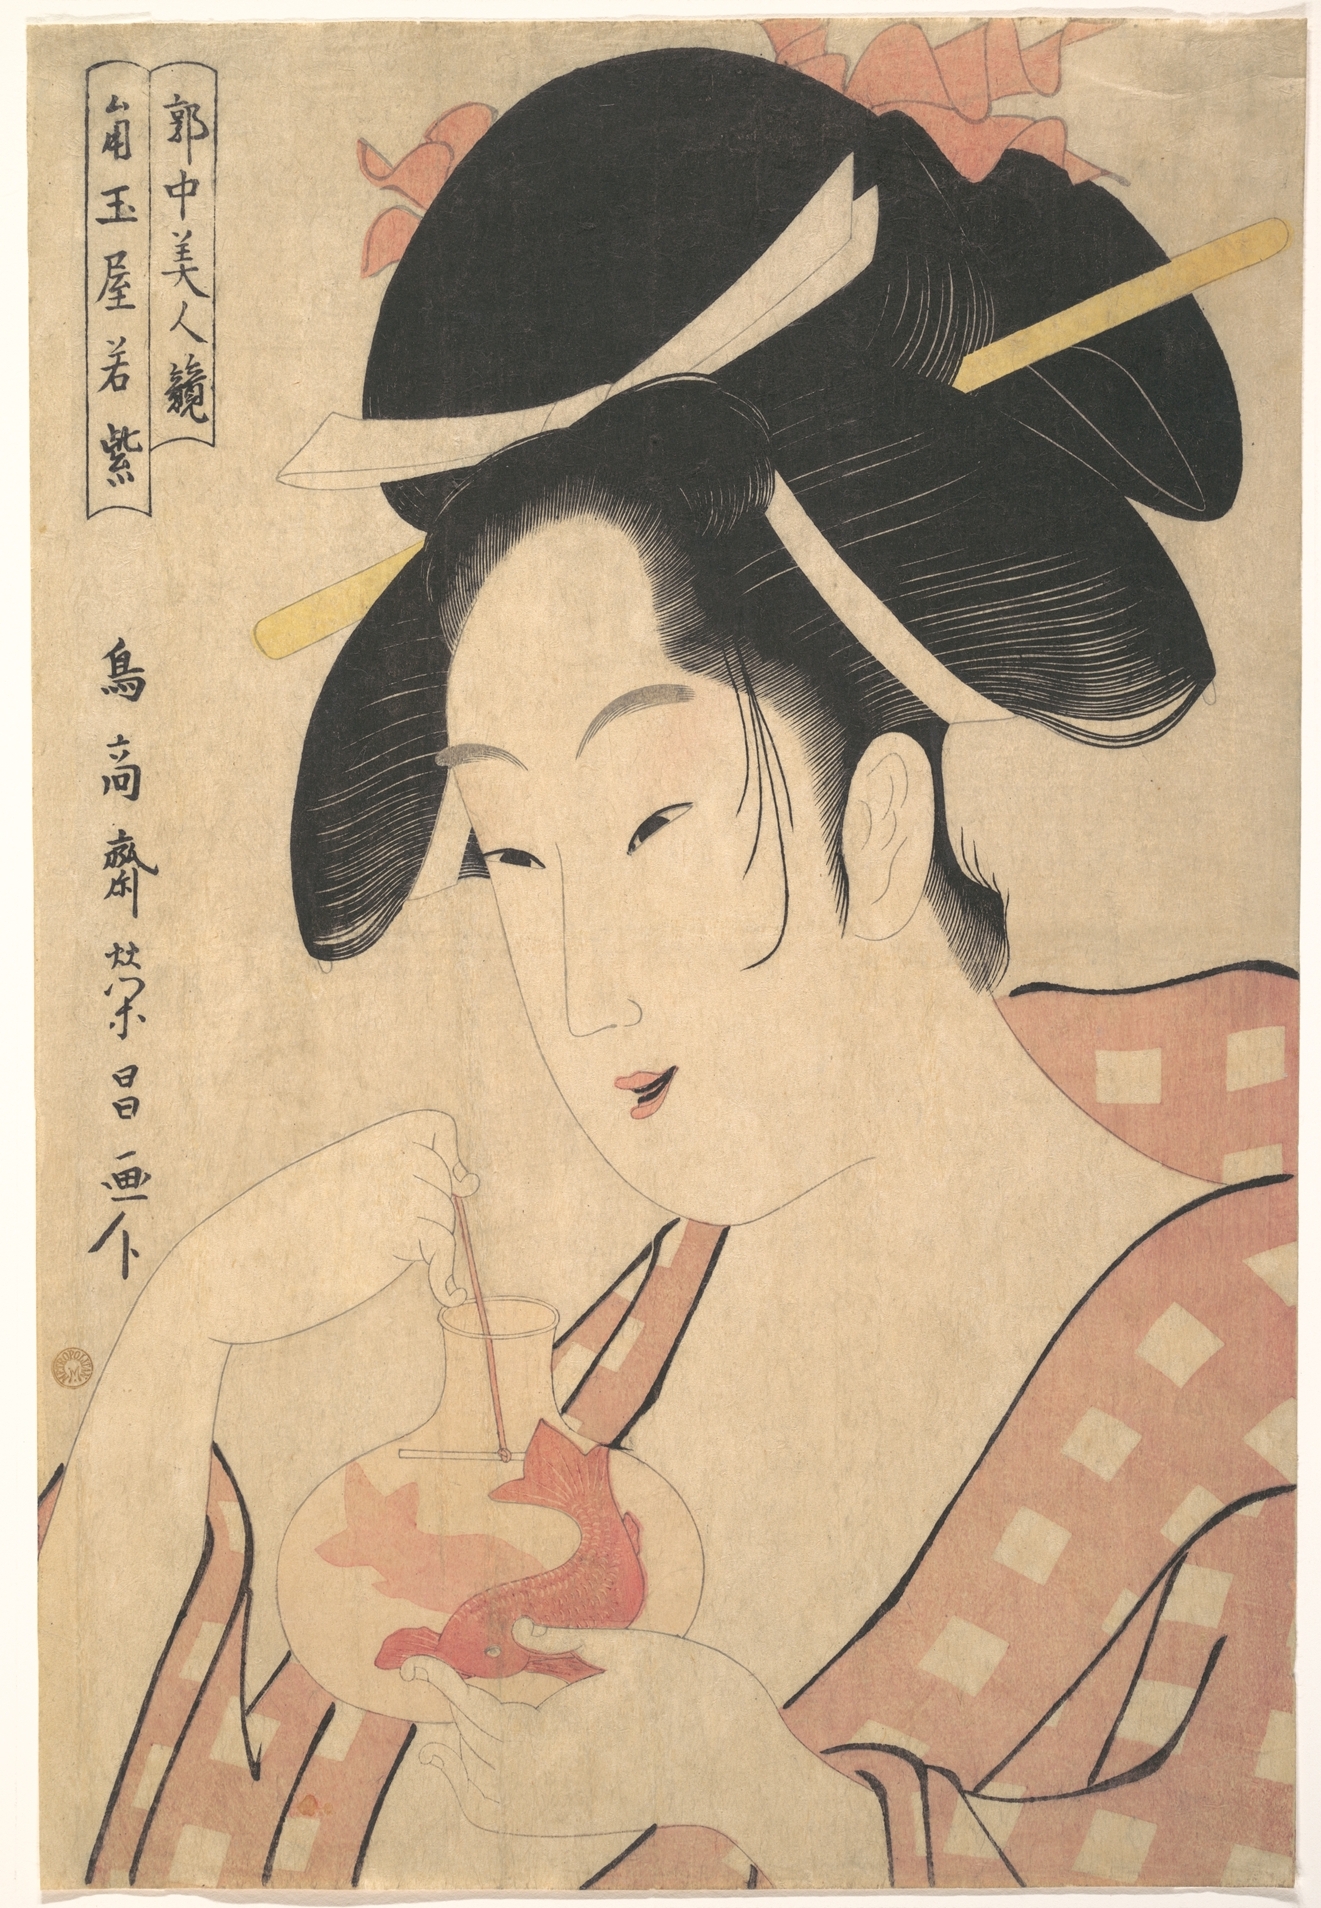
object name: print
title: Wakamurasaki of the Kadotamaya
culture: japanese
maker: chōkōsai eishō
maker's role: artist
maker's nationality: japanese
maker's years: 1793-1799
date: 1800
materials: ink, paper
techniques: woodblock print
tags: women,fish